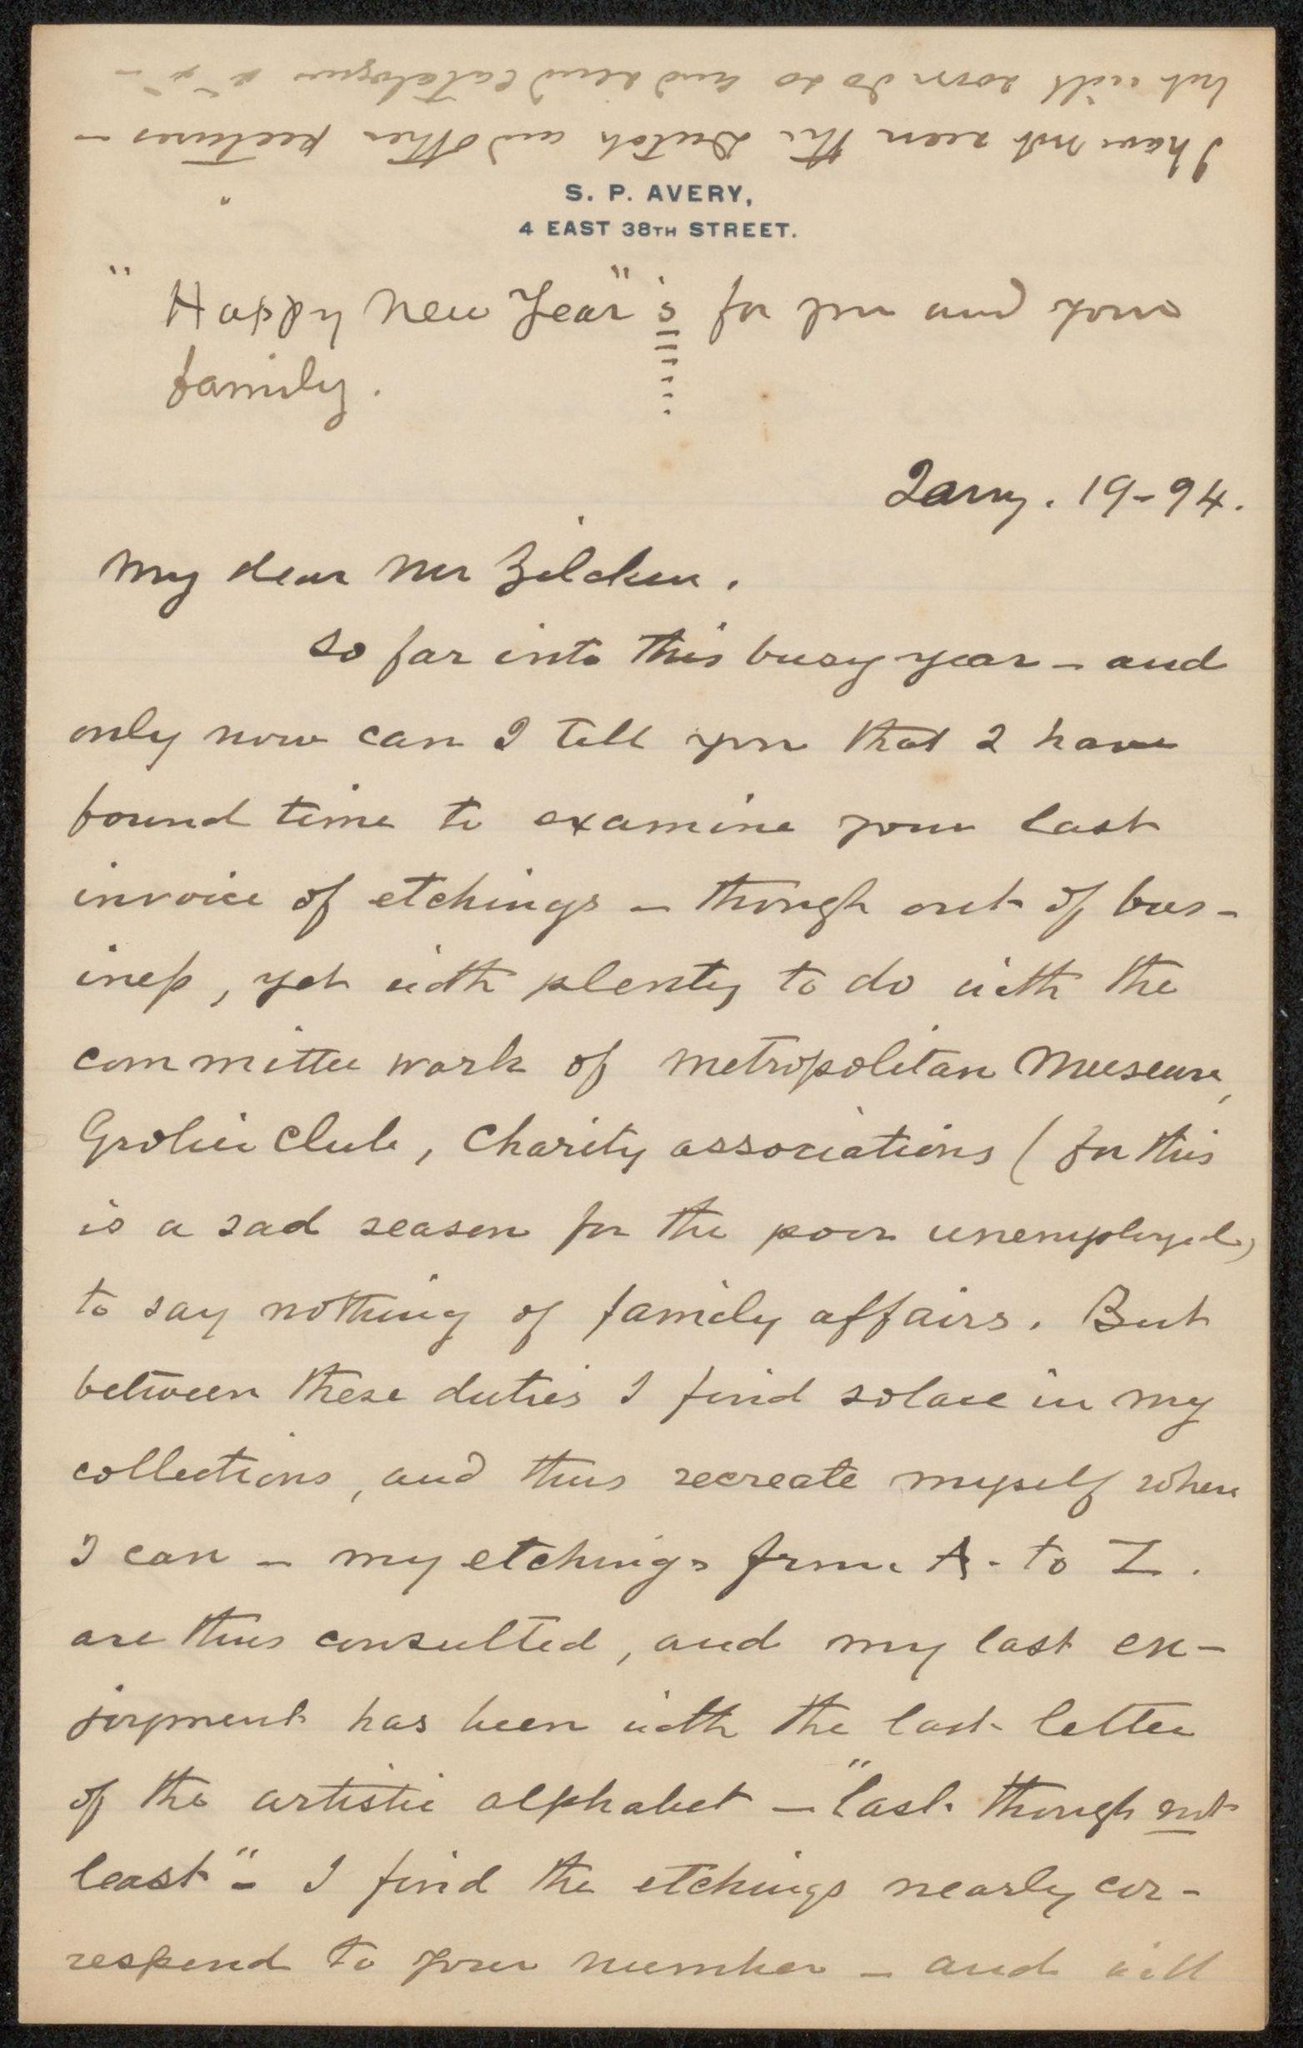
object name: letter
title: Brief aan Philip Zilcken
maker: samuel putnam avery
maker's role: verzamelaar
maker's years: 1822-1904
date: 1894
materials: ink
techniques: pen, printing, writing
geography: new york city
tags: arnhem, painter, print maker, draughtsman, anton mauve, paris, paul verlaine, philip zilcken, art trade, art shop, the graphic arts, art collecting, money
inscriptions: collector's mark: ‘RPK’